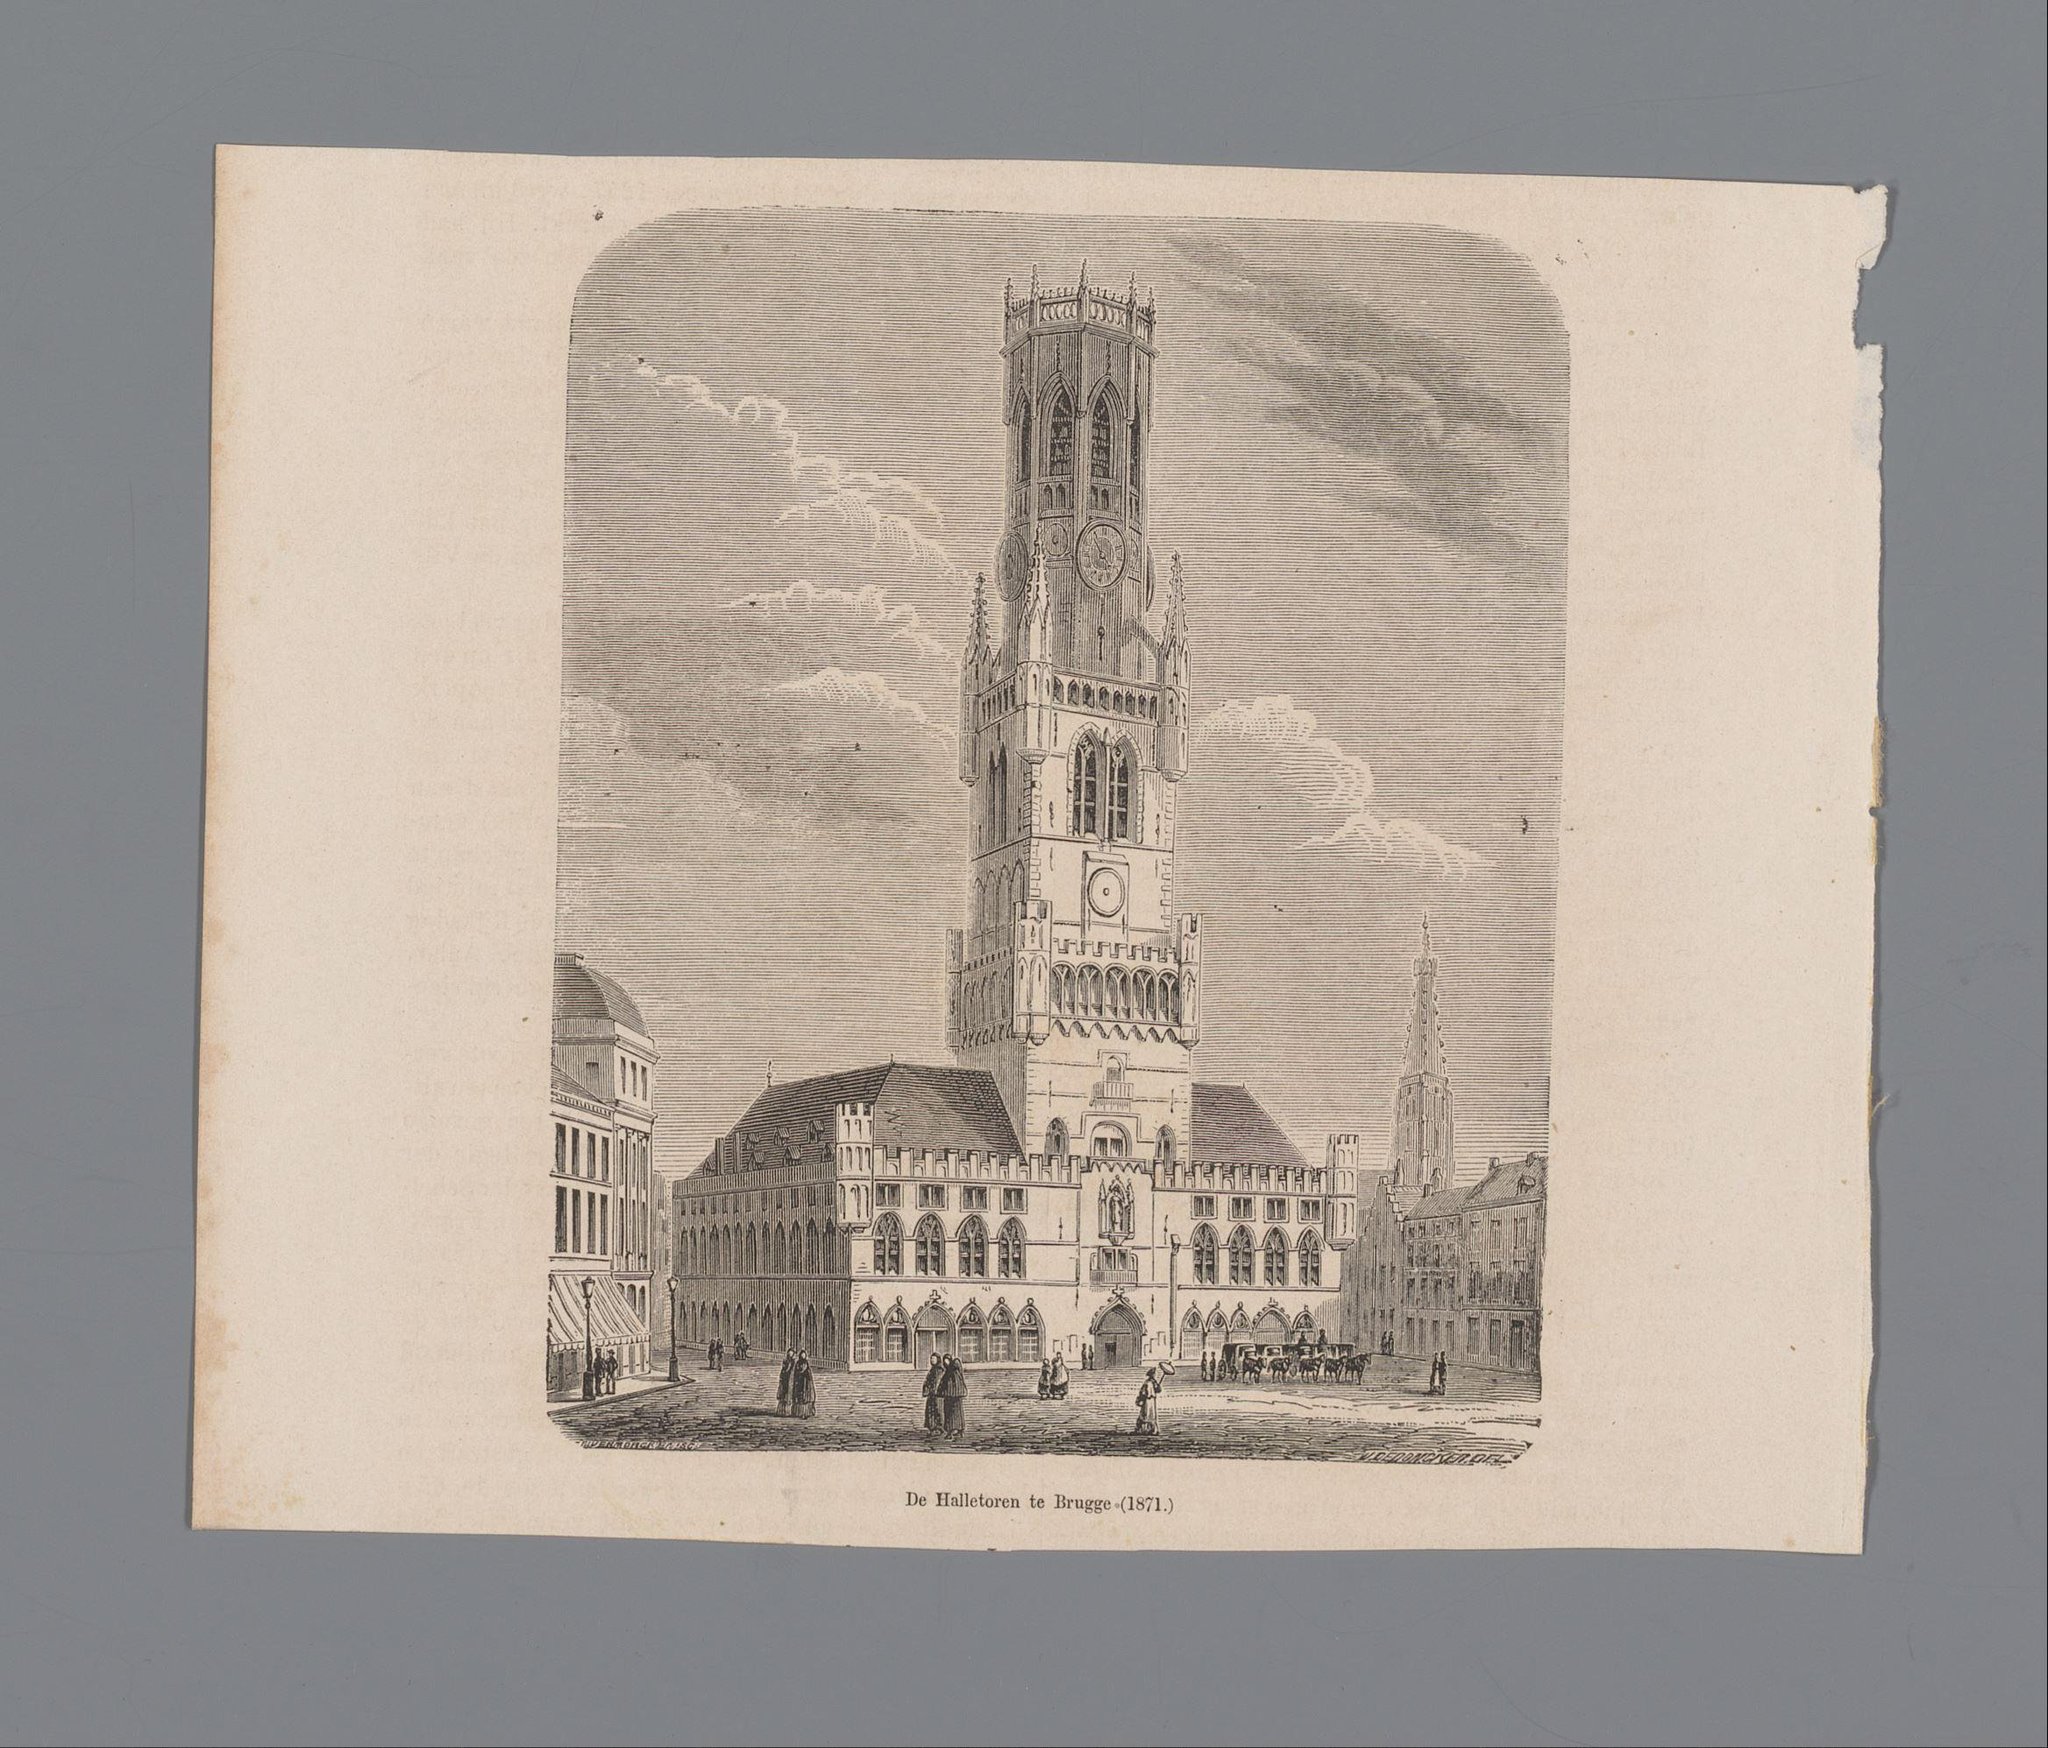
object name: print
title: Gezicht op het Belfort te Brugge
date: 1873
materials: paper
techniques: letterpress printing, engraving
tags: landscape with bridge, viaduct or aqueduct, tower (of house or building), bruges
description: Prent uit: Witkamp, Pieter Harme. Geschiedenis der zeventien Nederlanden. S.l.: Van Bakkenes, 1873, dl. 1, p. 536.